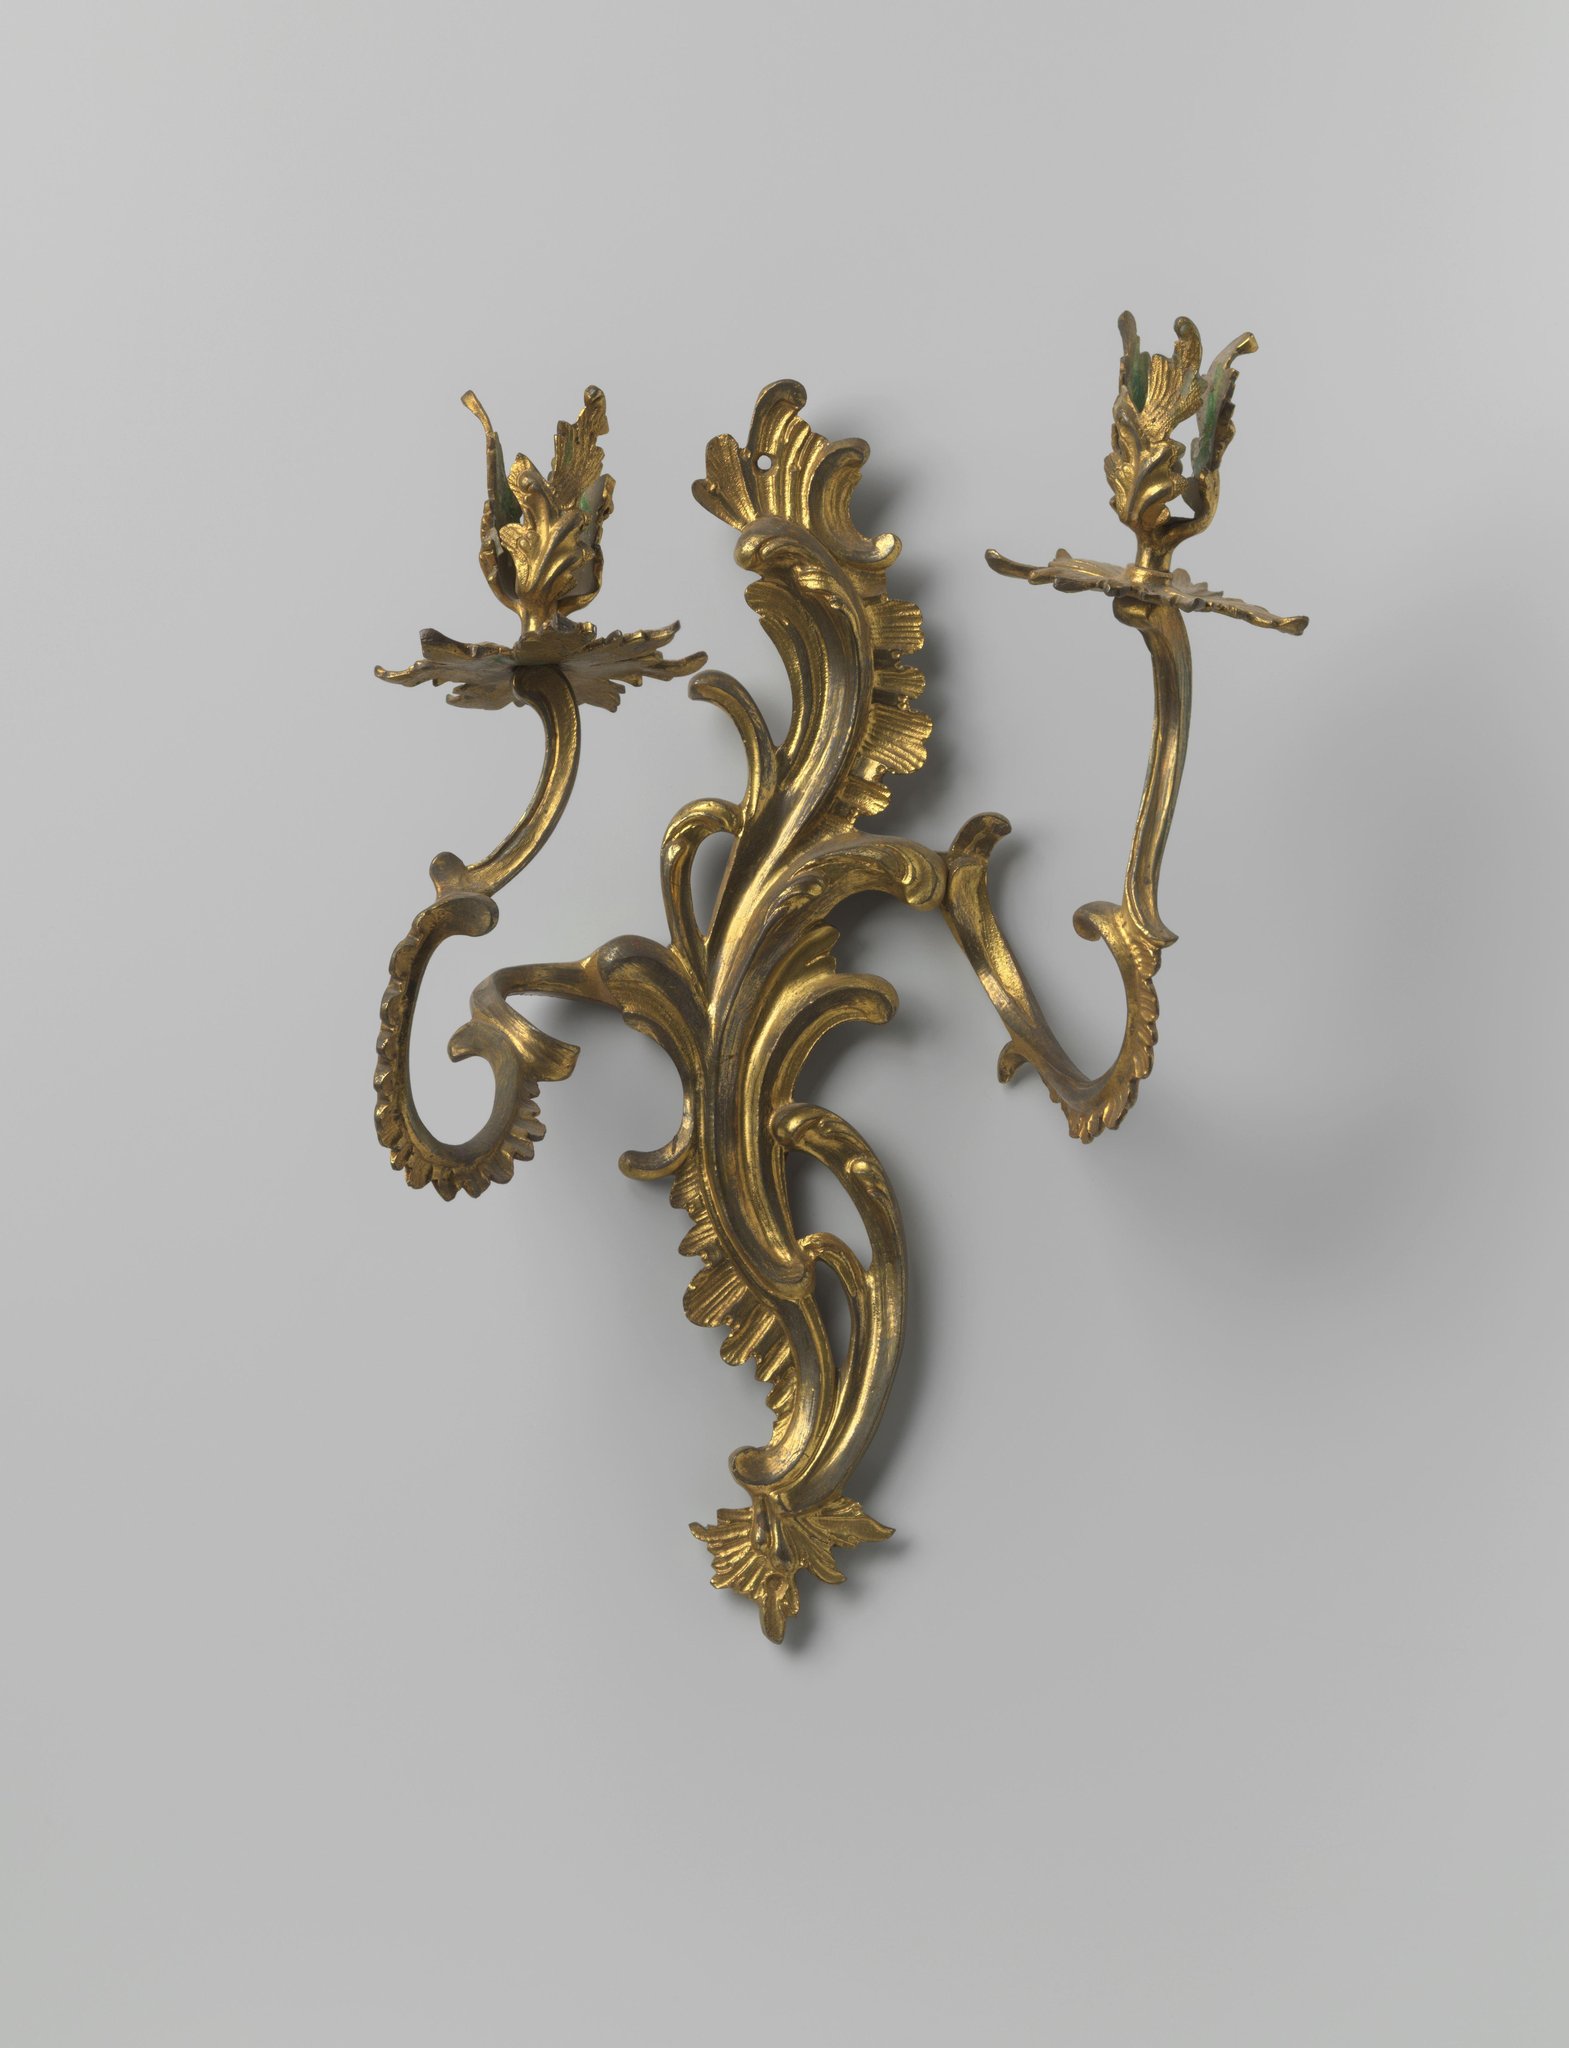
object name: lighting device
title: Wandarm van verguld koper, versierd met C- en S-voluutvormige acanthusbladeren.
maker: Anonymous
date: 1750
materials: copper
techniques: gilding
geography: northern netherlands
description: Wandarm van verguld koper. De applique bestaat uit drie in elkaar overvloeiende C-vormige acanthusranken. Hieruit springen links en rechts twee S- en C-vormige voluten naar voren, waarop de kaarsenhouders, gevormd door drie acanthusbladeren, geschroefd zijn. Onder de kaarsenhouders zijn rozetvormige vetvangers aangebracht. Zie: BK-1953-3-b.